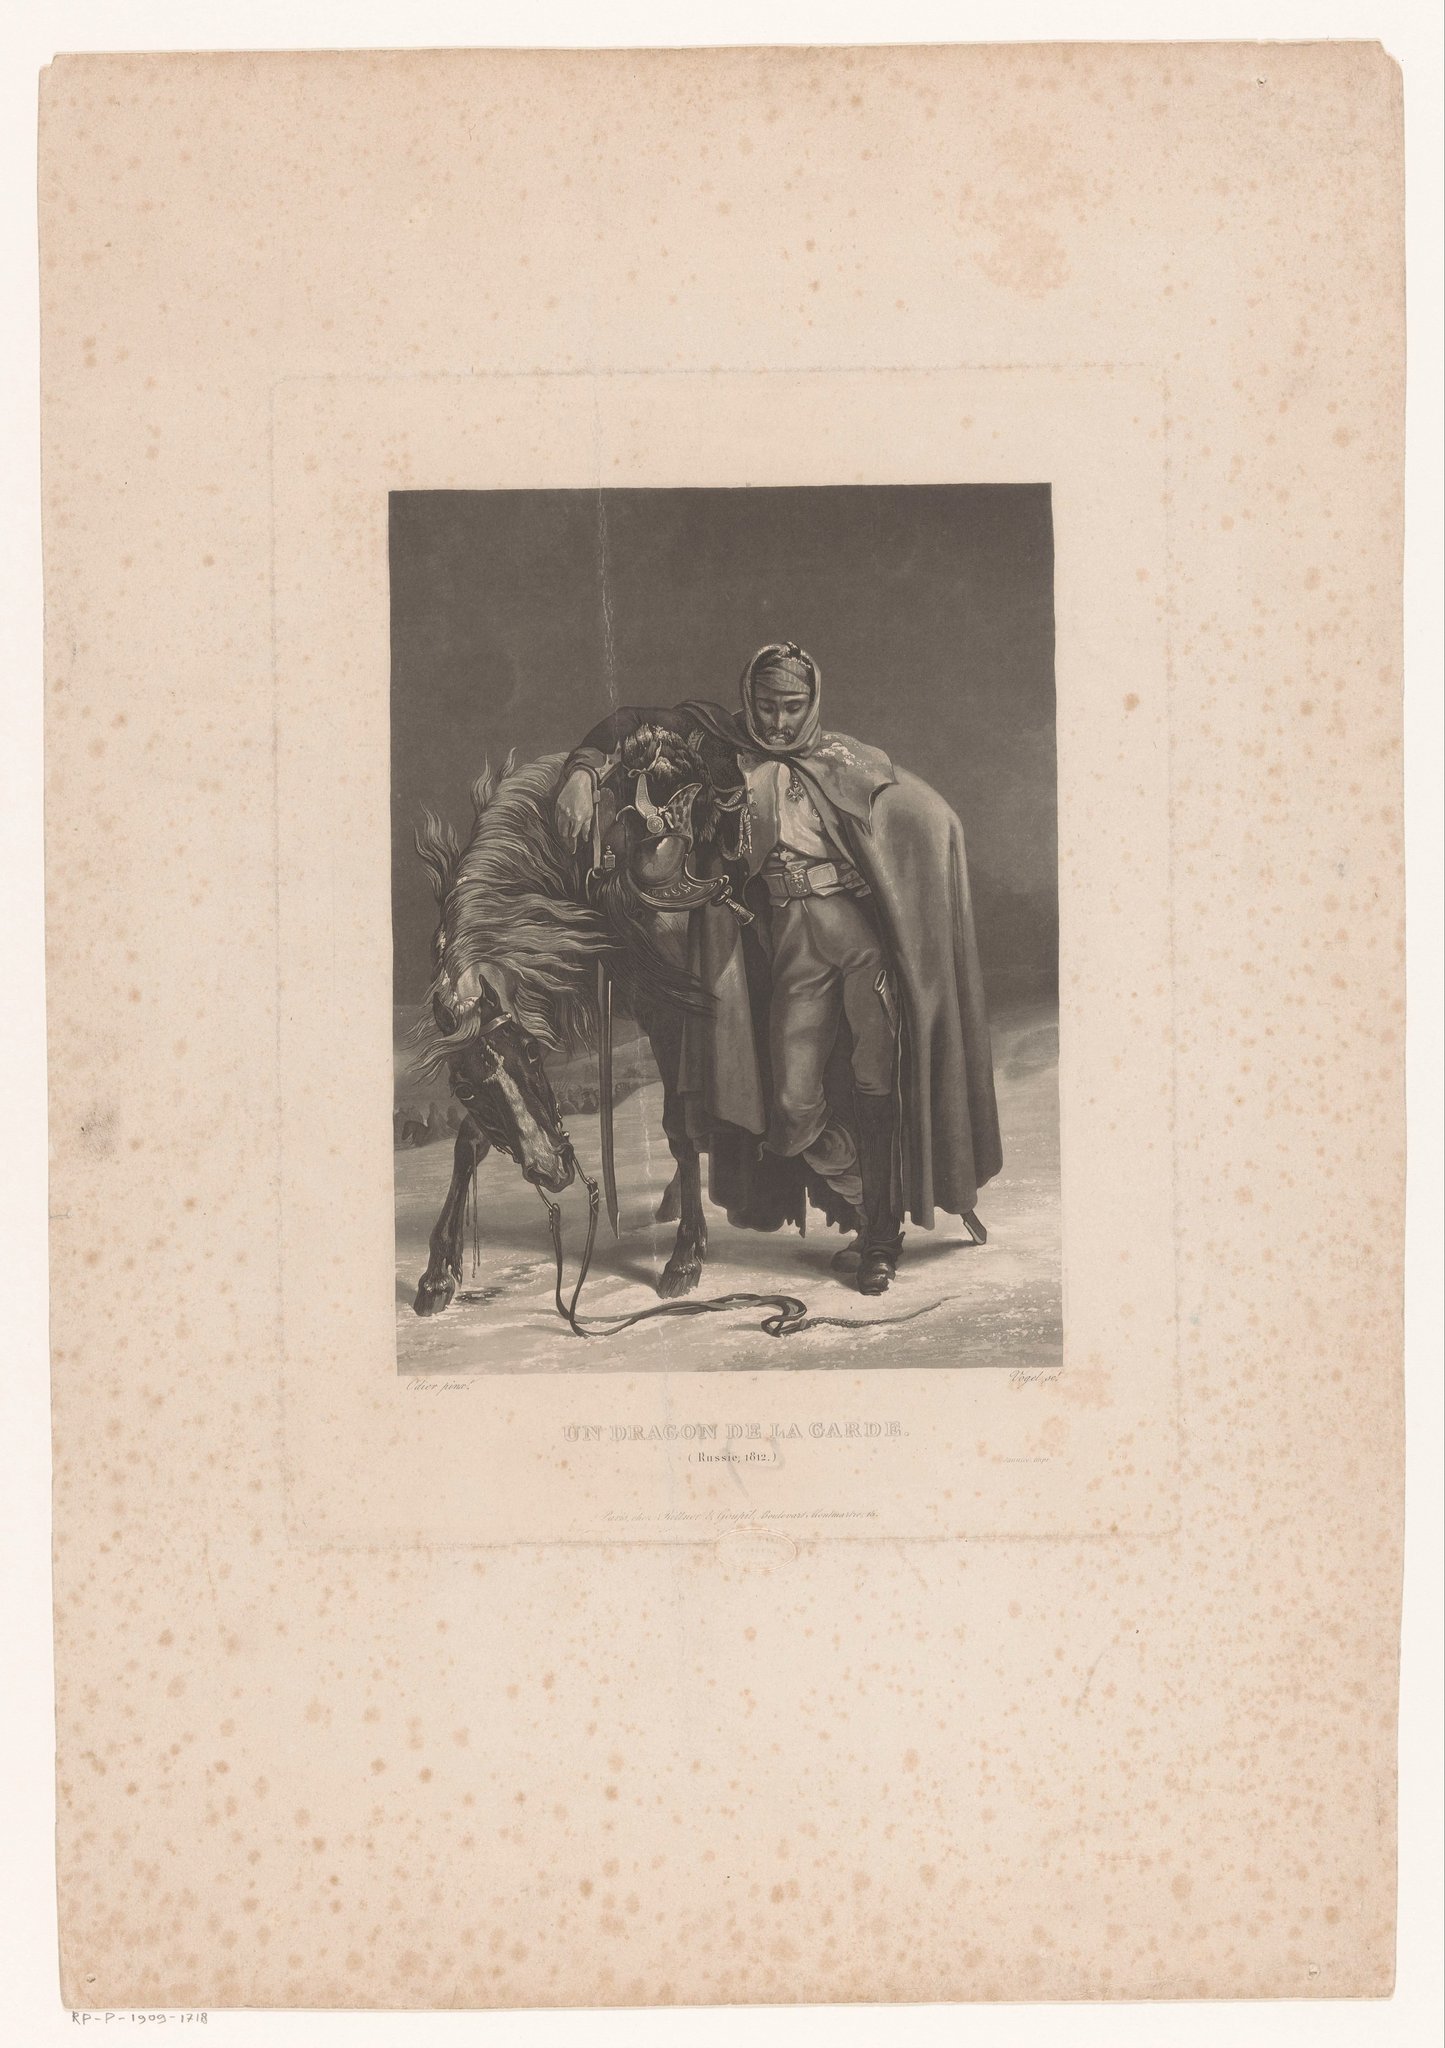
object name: print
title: Un dragon de la Garde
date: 1831-1840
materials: paper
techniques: aquatint, etching, roulette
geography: paris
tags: private soldier (+ infantry), fighting horses, preparation for battle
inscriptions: collector's mark: Lugt 2228, check stamp: Lugt 2140